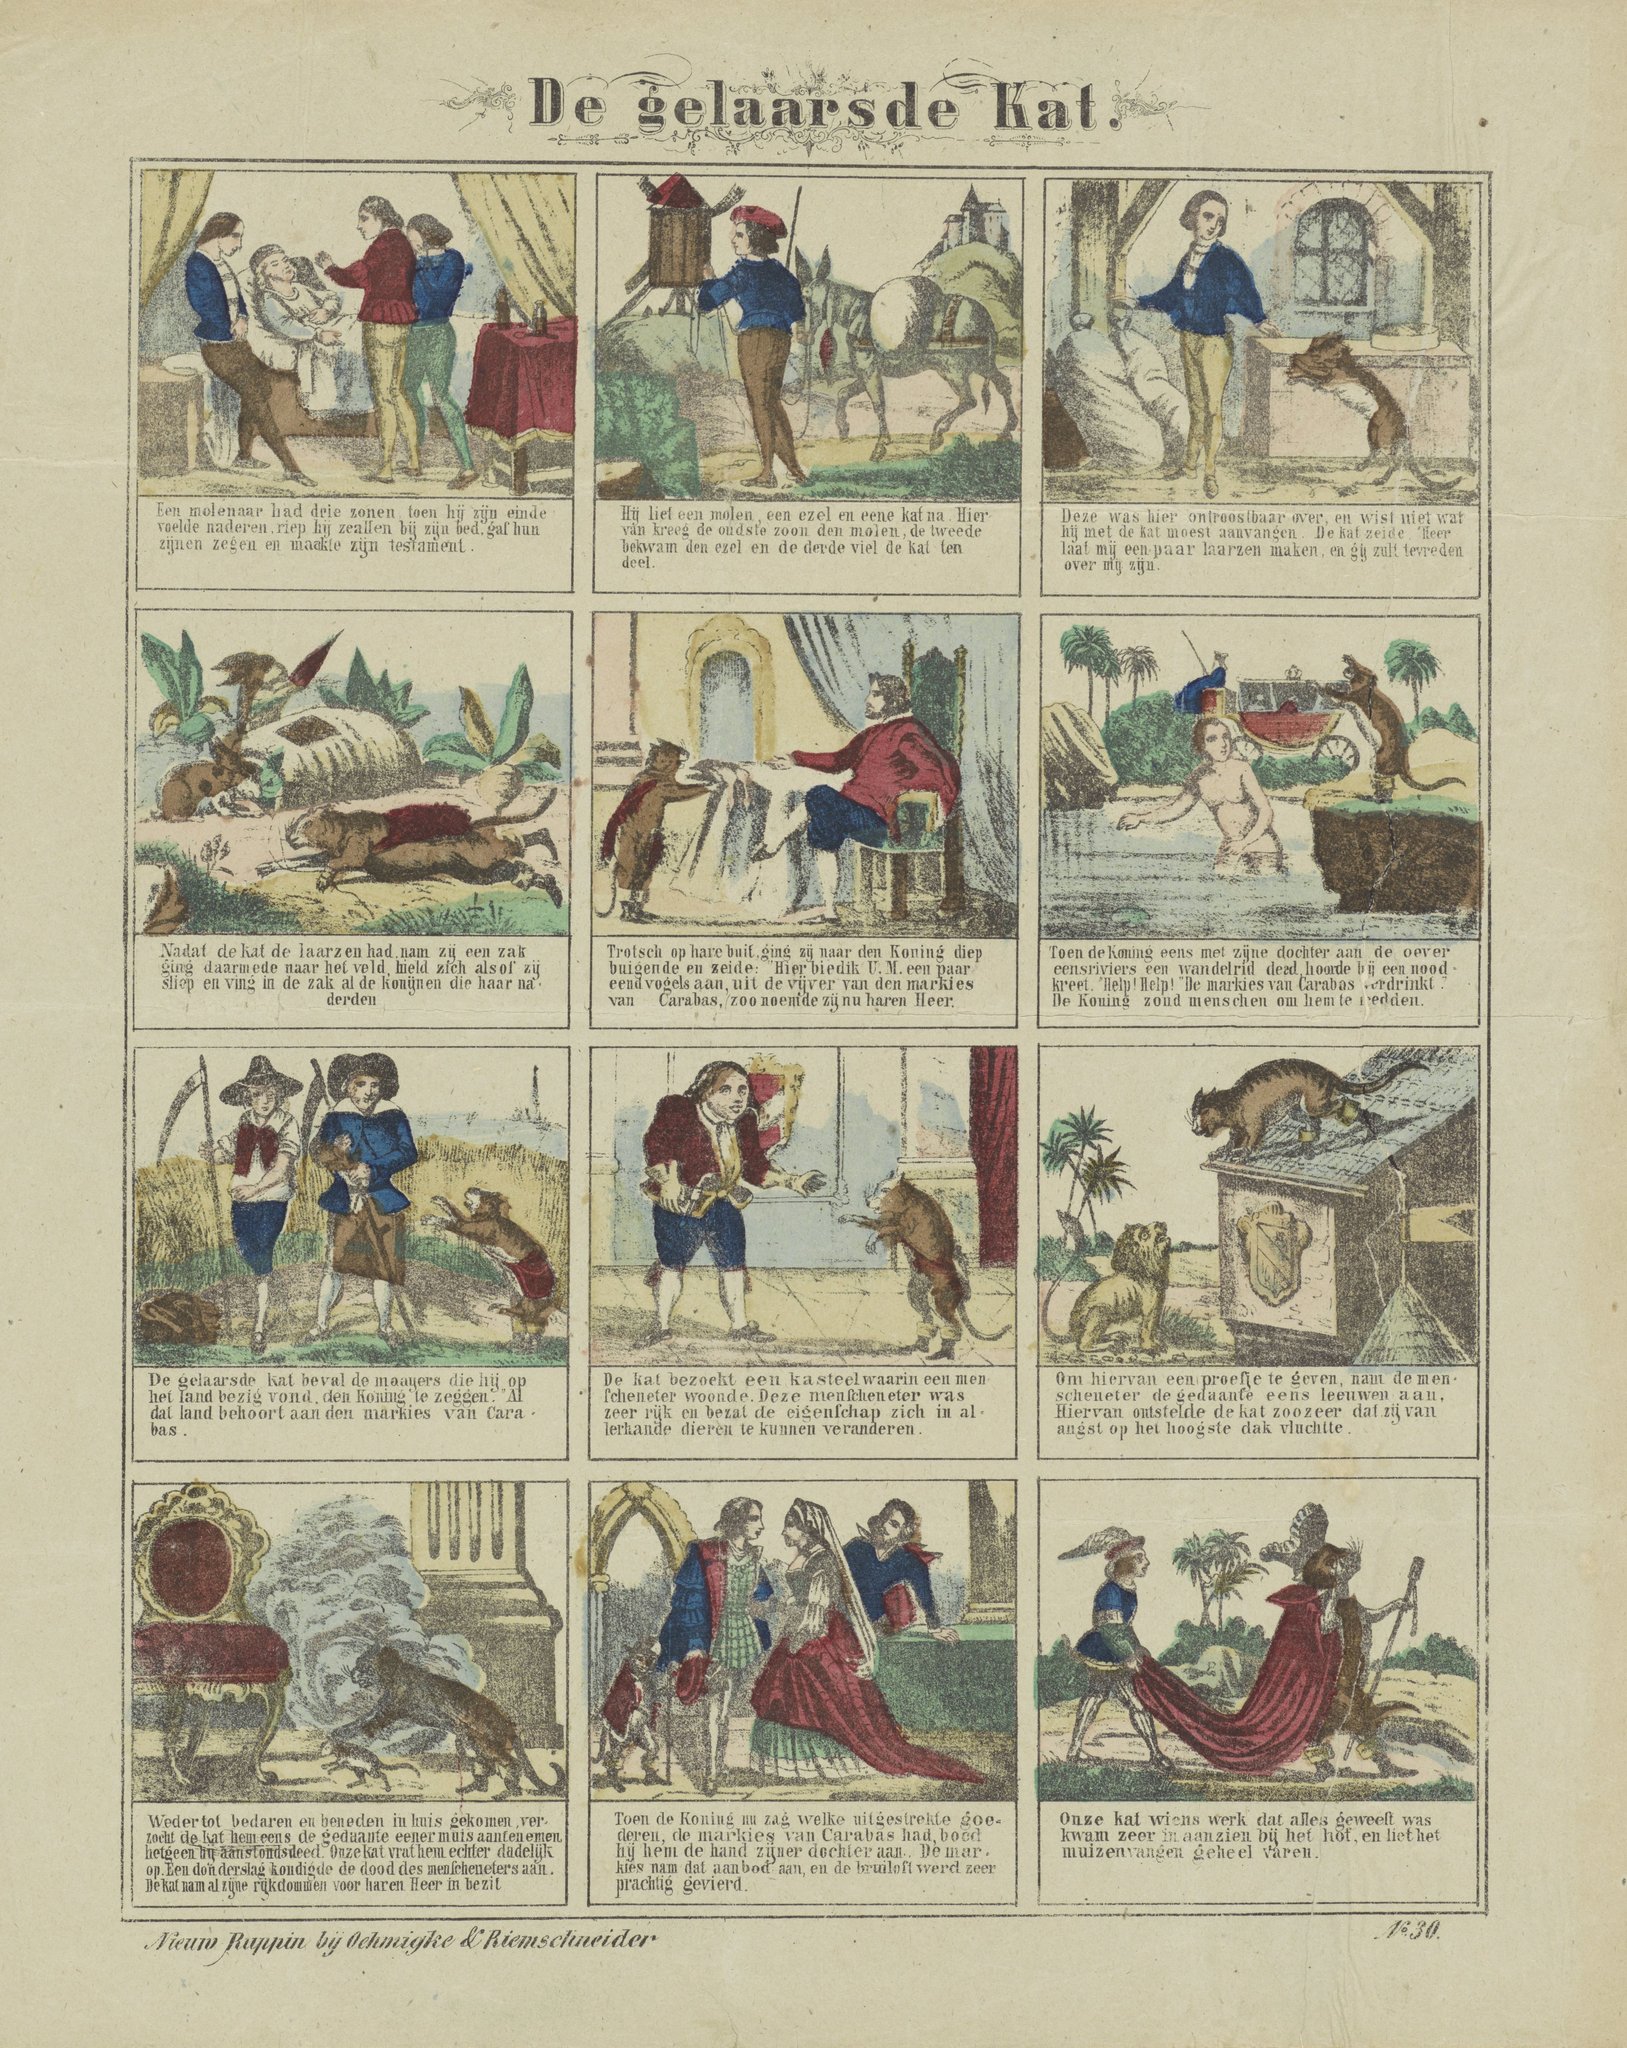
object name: popular print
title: De gelaarsde kat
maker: Anonymous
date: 1828-1937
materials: paper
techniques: hand coloring, letterpress printing, lithograph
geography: neuruppin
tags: tales and fairy tales: puss in boots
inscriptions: collector's mark: Lugt 2760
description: Blad met 12 voorstellingen uit het verhaal van de gelaarsde kat. Onder elke afbeelding een onderschrift. Genummerd rechtsonder: No. 30.